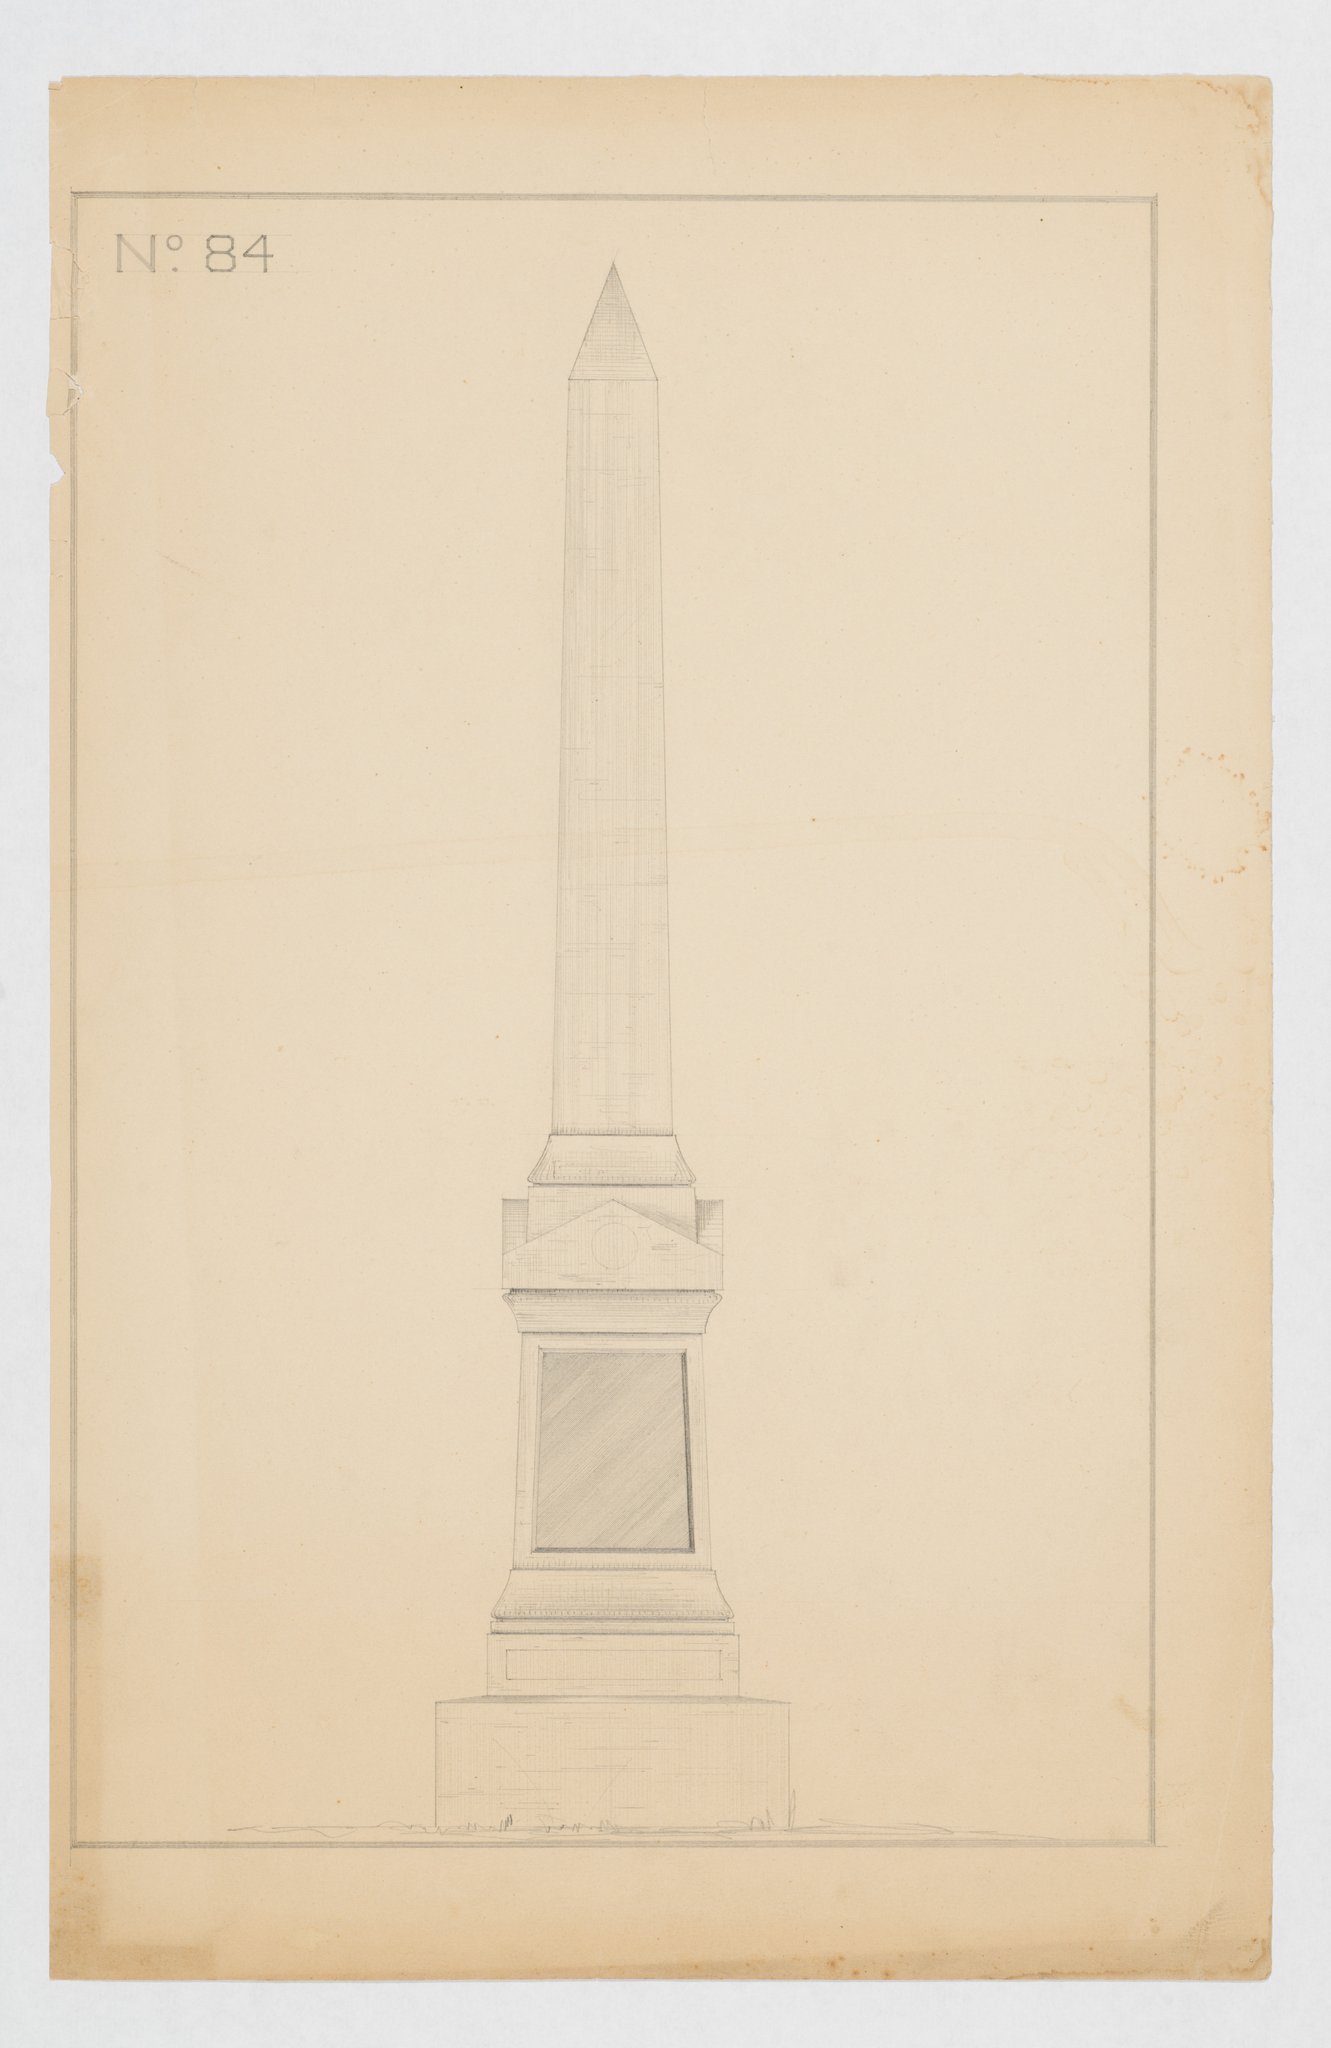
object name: drawing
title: Obelisk Grave Monument, No. 84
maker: alexander maxwell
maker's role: artist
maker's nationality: american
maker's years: 1838-1880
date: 1840-1880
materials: graphite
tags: obelisks